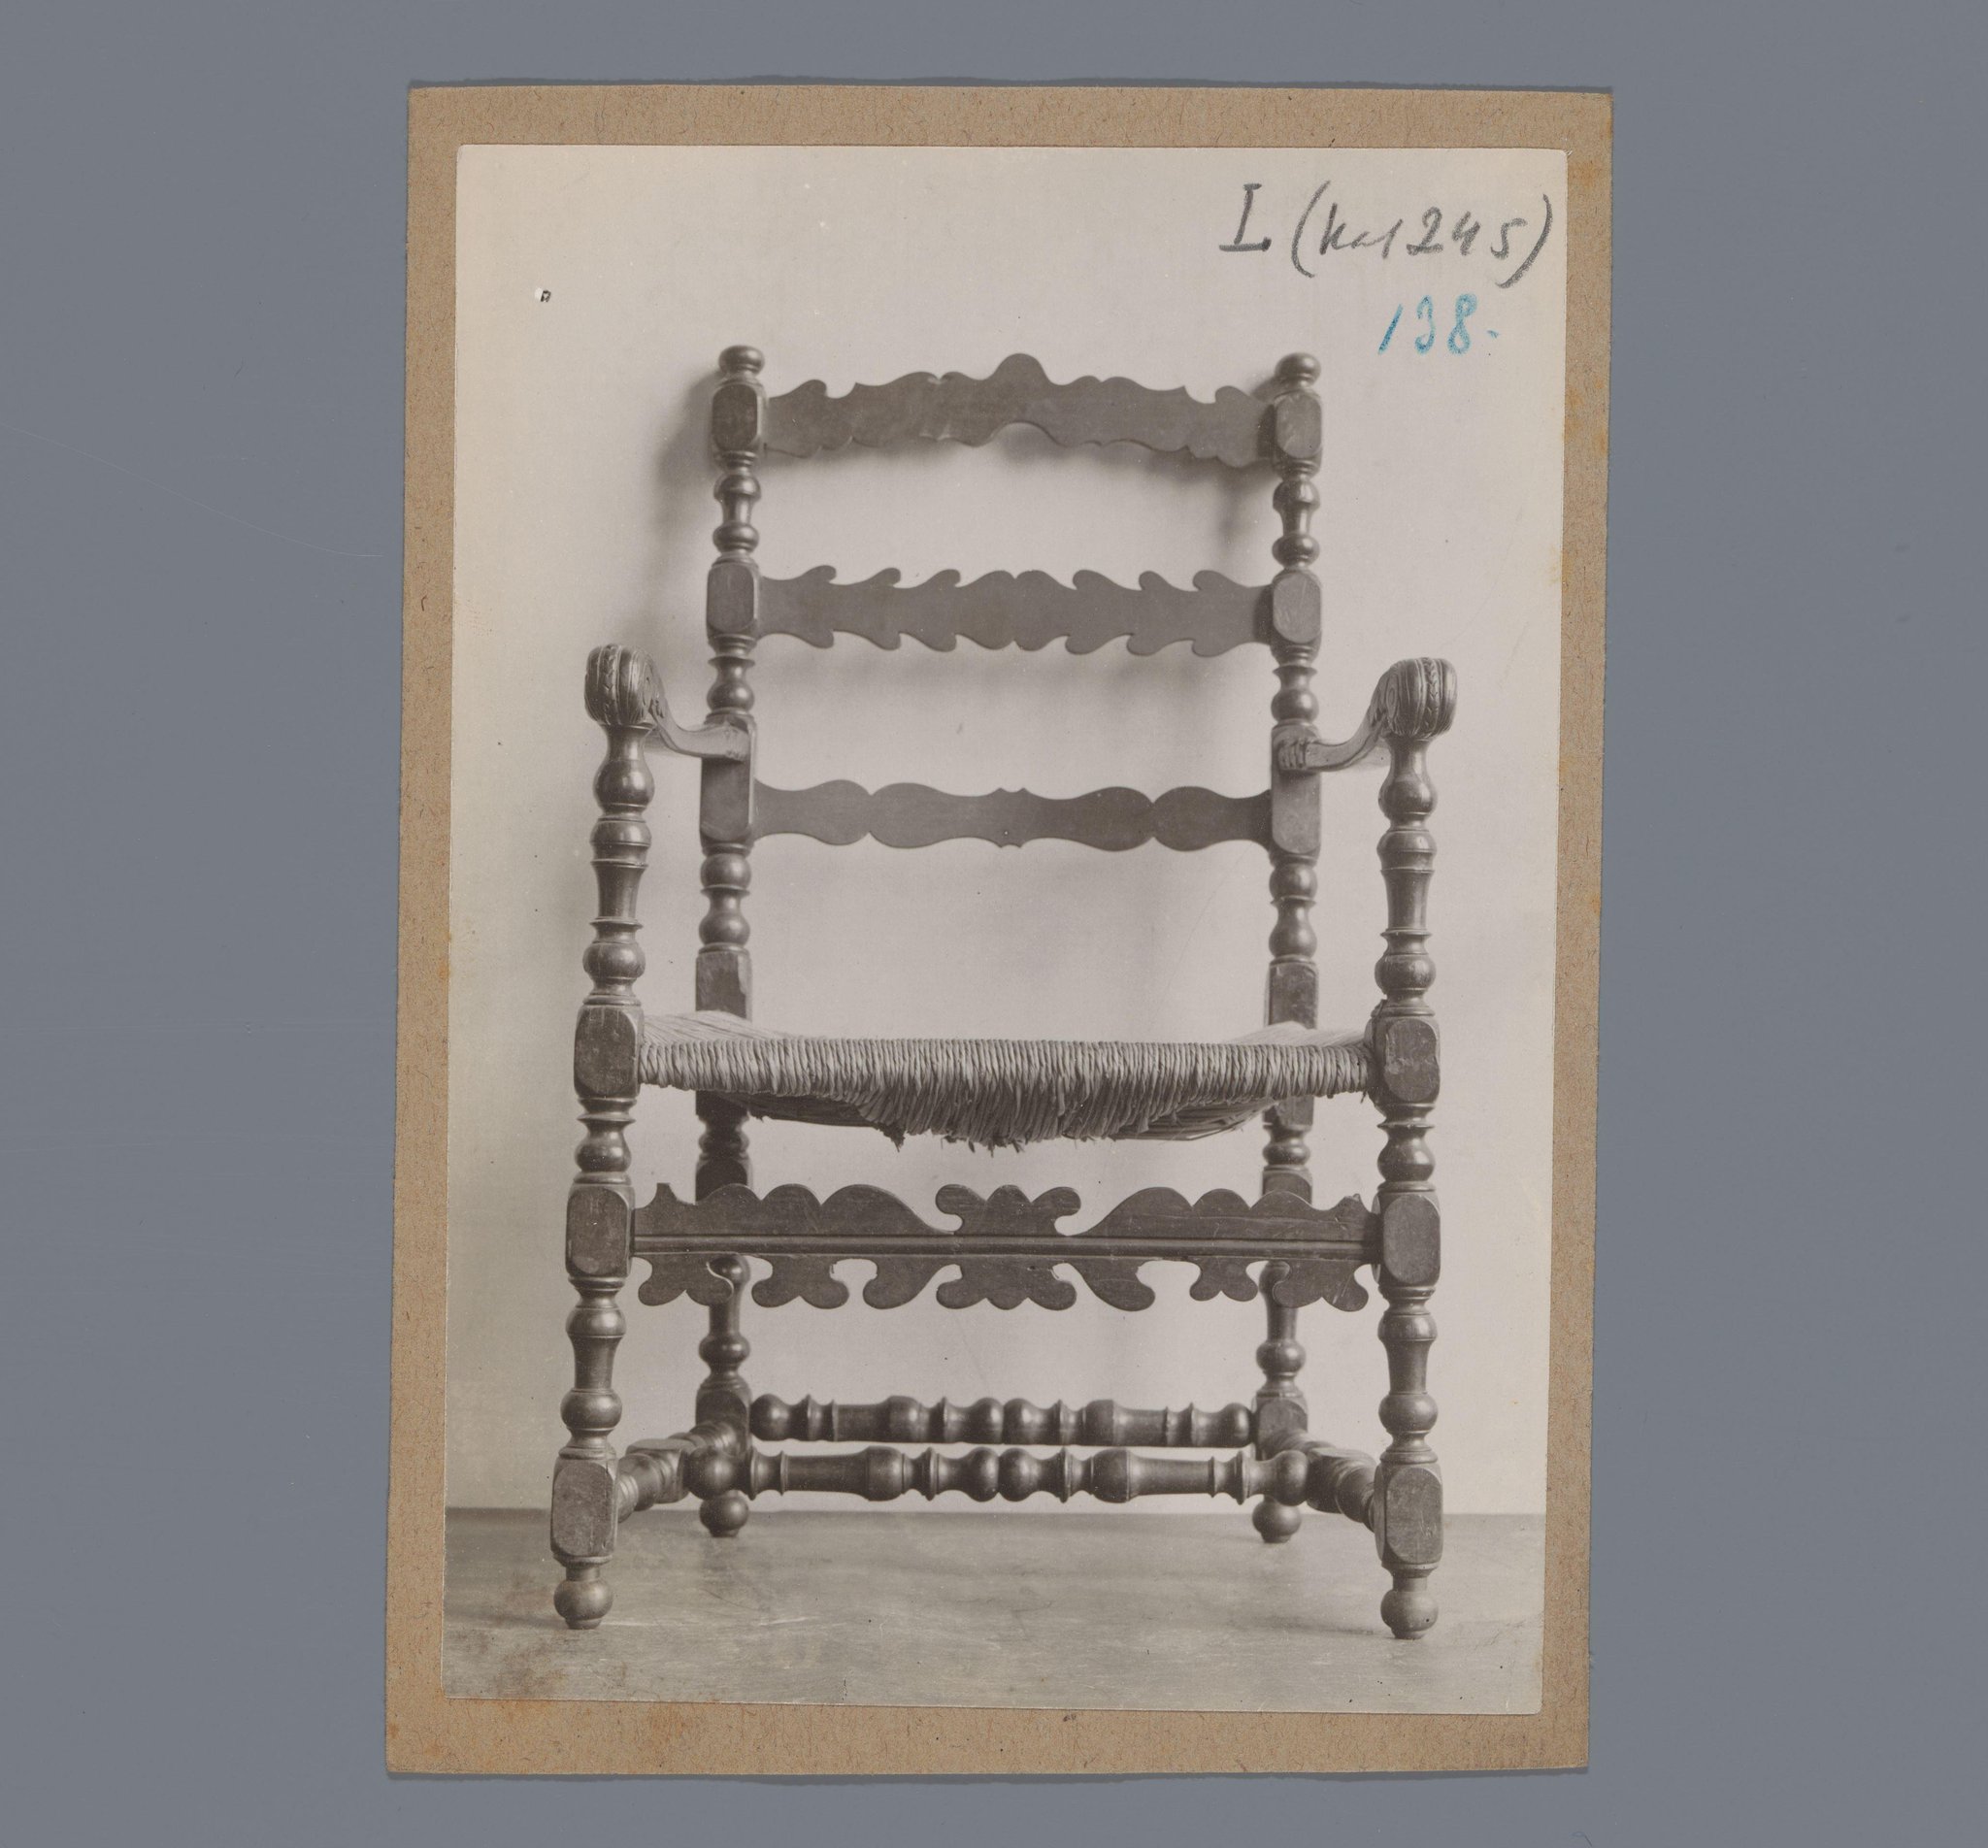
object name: photograph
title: Stoel met een opengewerkte rug en een rieten zitting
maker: Anonymous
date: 1875-1900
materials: photographic support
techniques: matte daylight collodion silver print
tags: chair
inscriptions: number: ‘I (kat 245) 138’, collector's mark: ‘Instituut voor kunst-nijverheidsonderwijs Gabriël Metsustraat No. 16, Amsterdam’